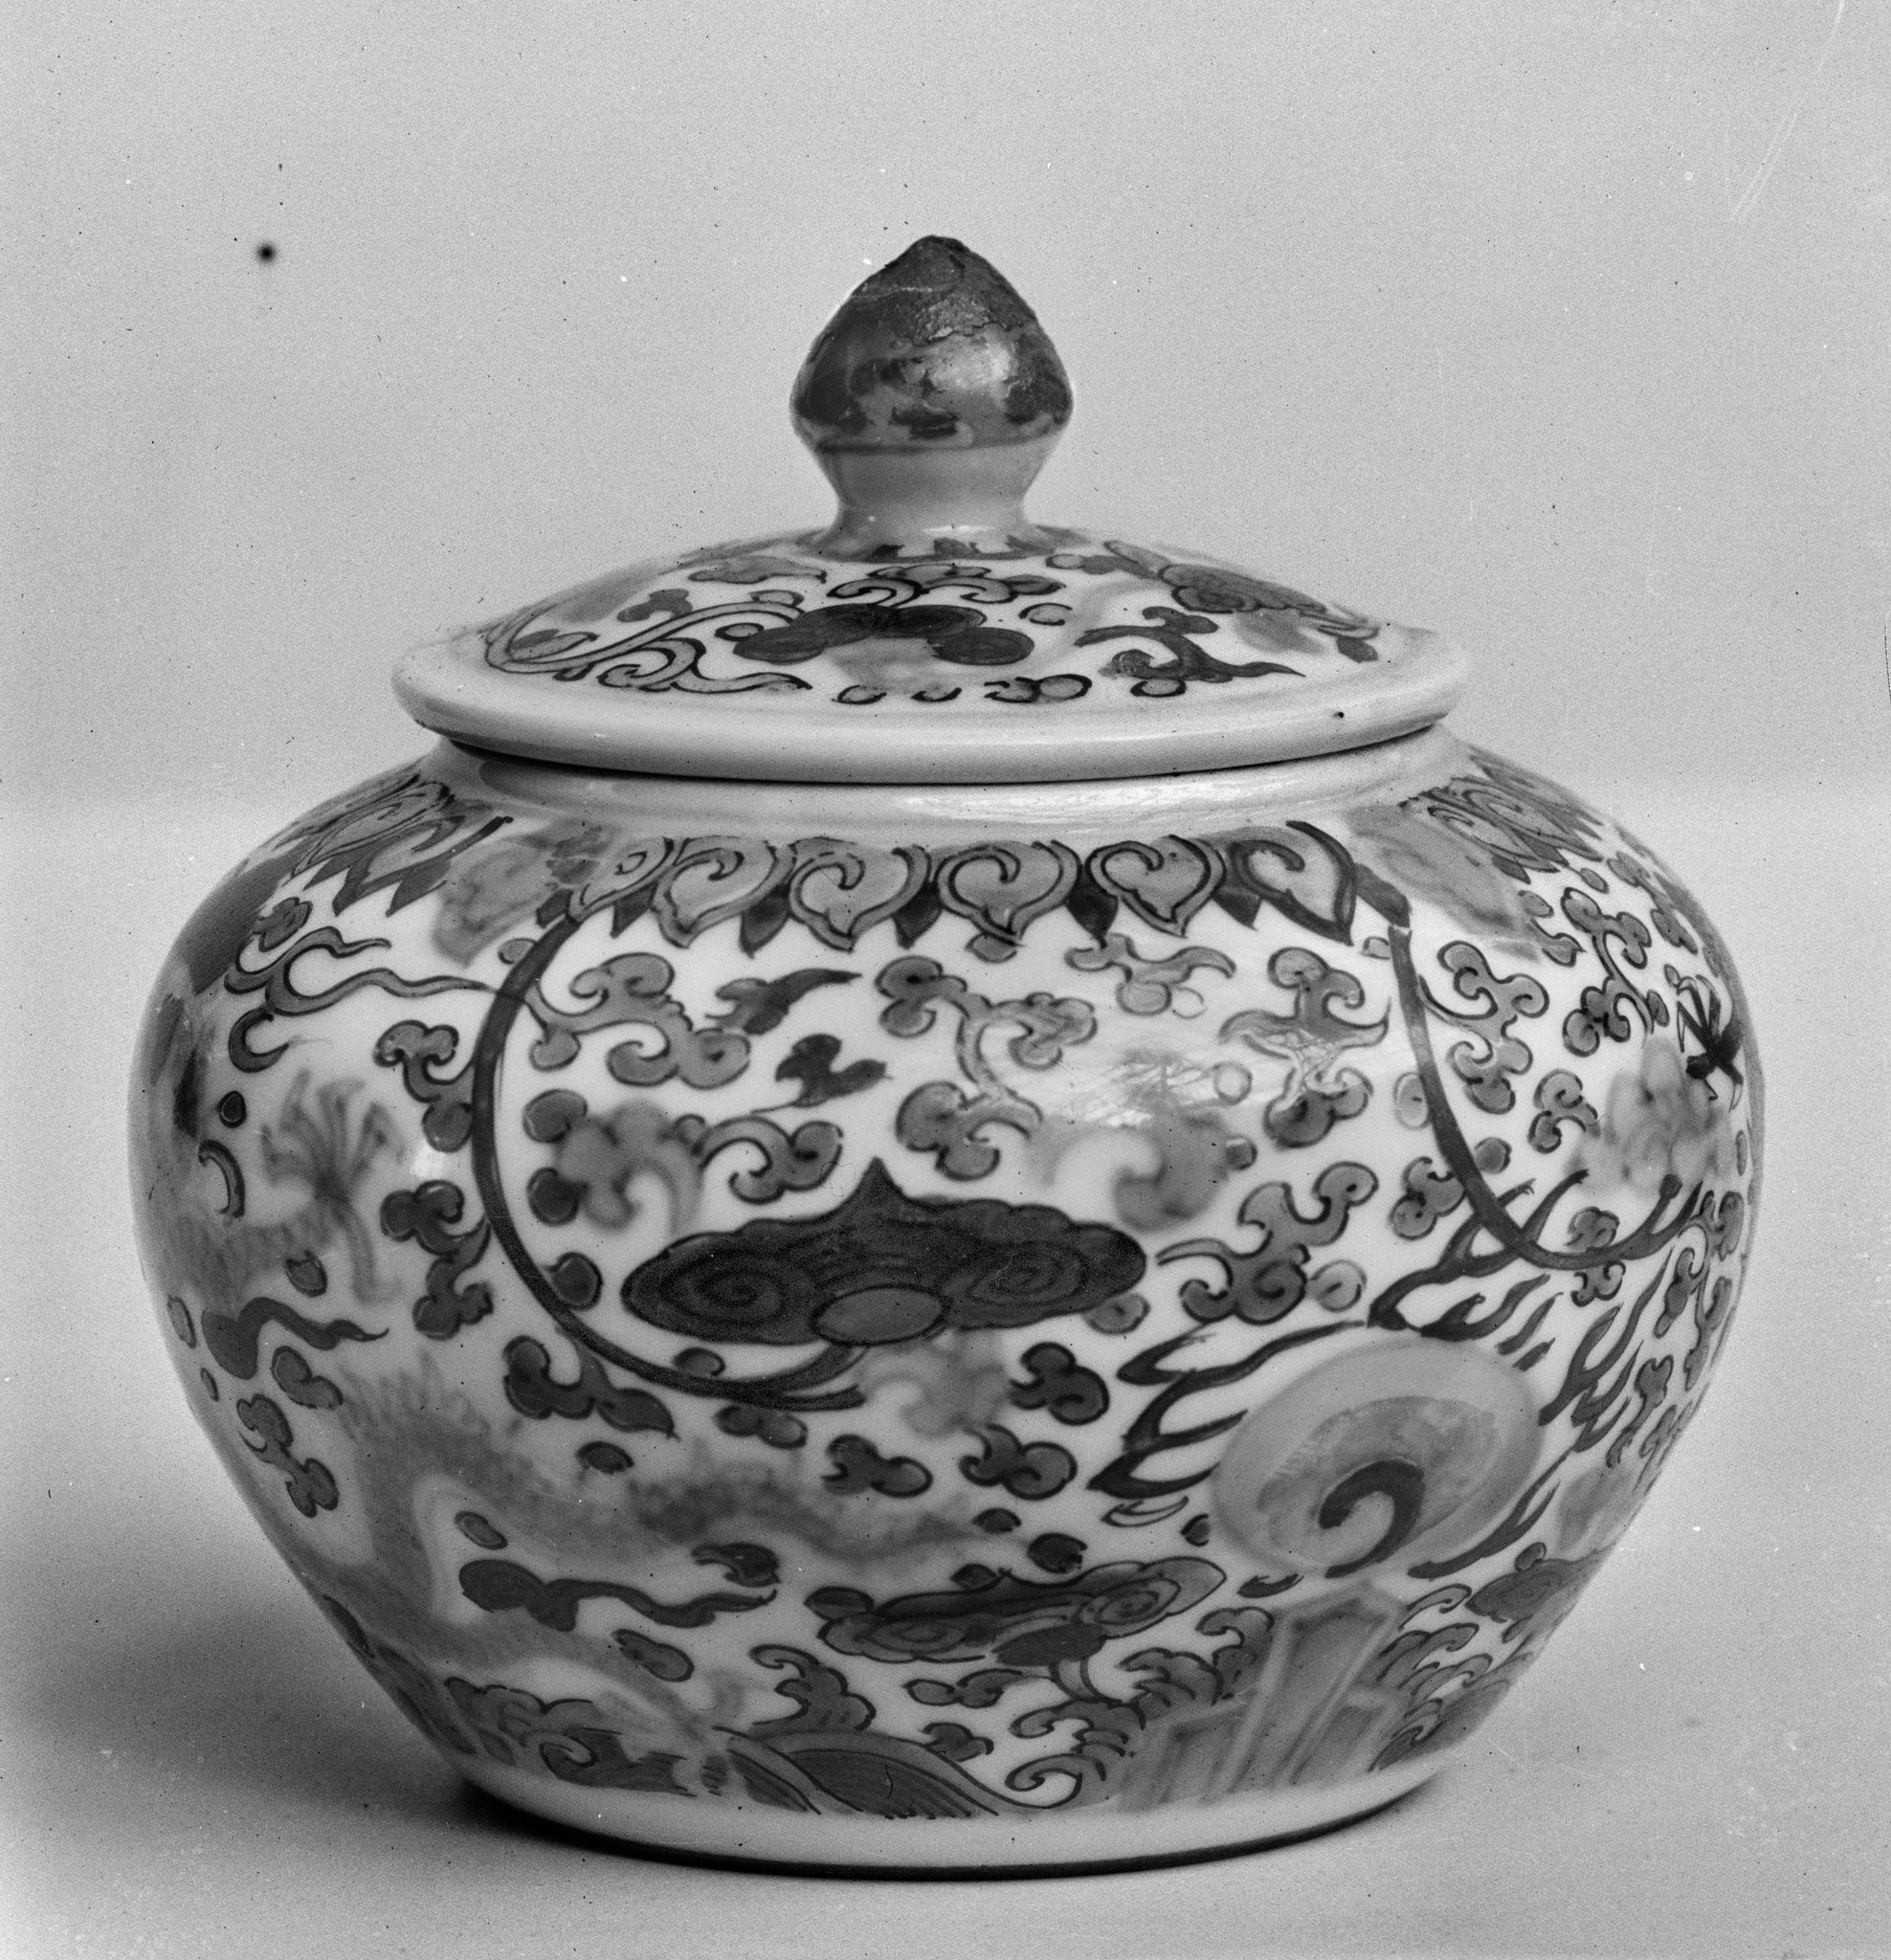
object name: covered jar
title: Covered jar with dragons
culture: chinese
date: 1701-1800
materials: cobalt, enamel, porcelain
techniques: overglaze, painting, polychrome, underglaze